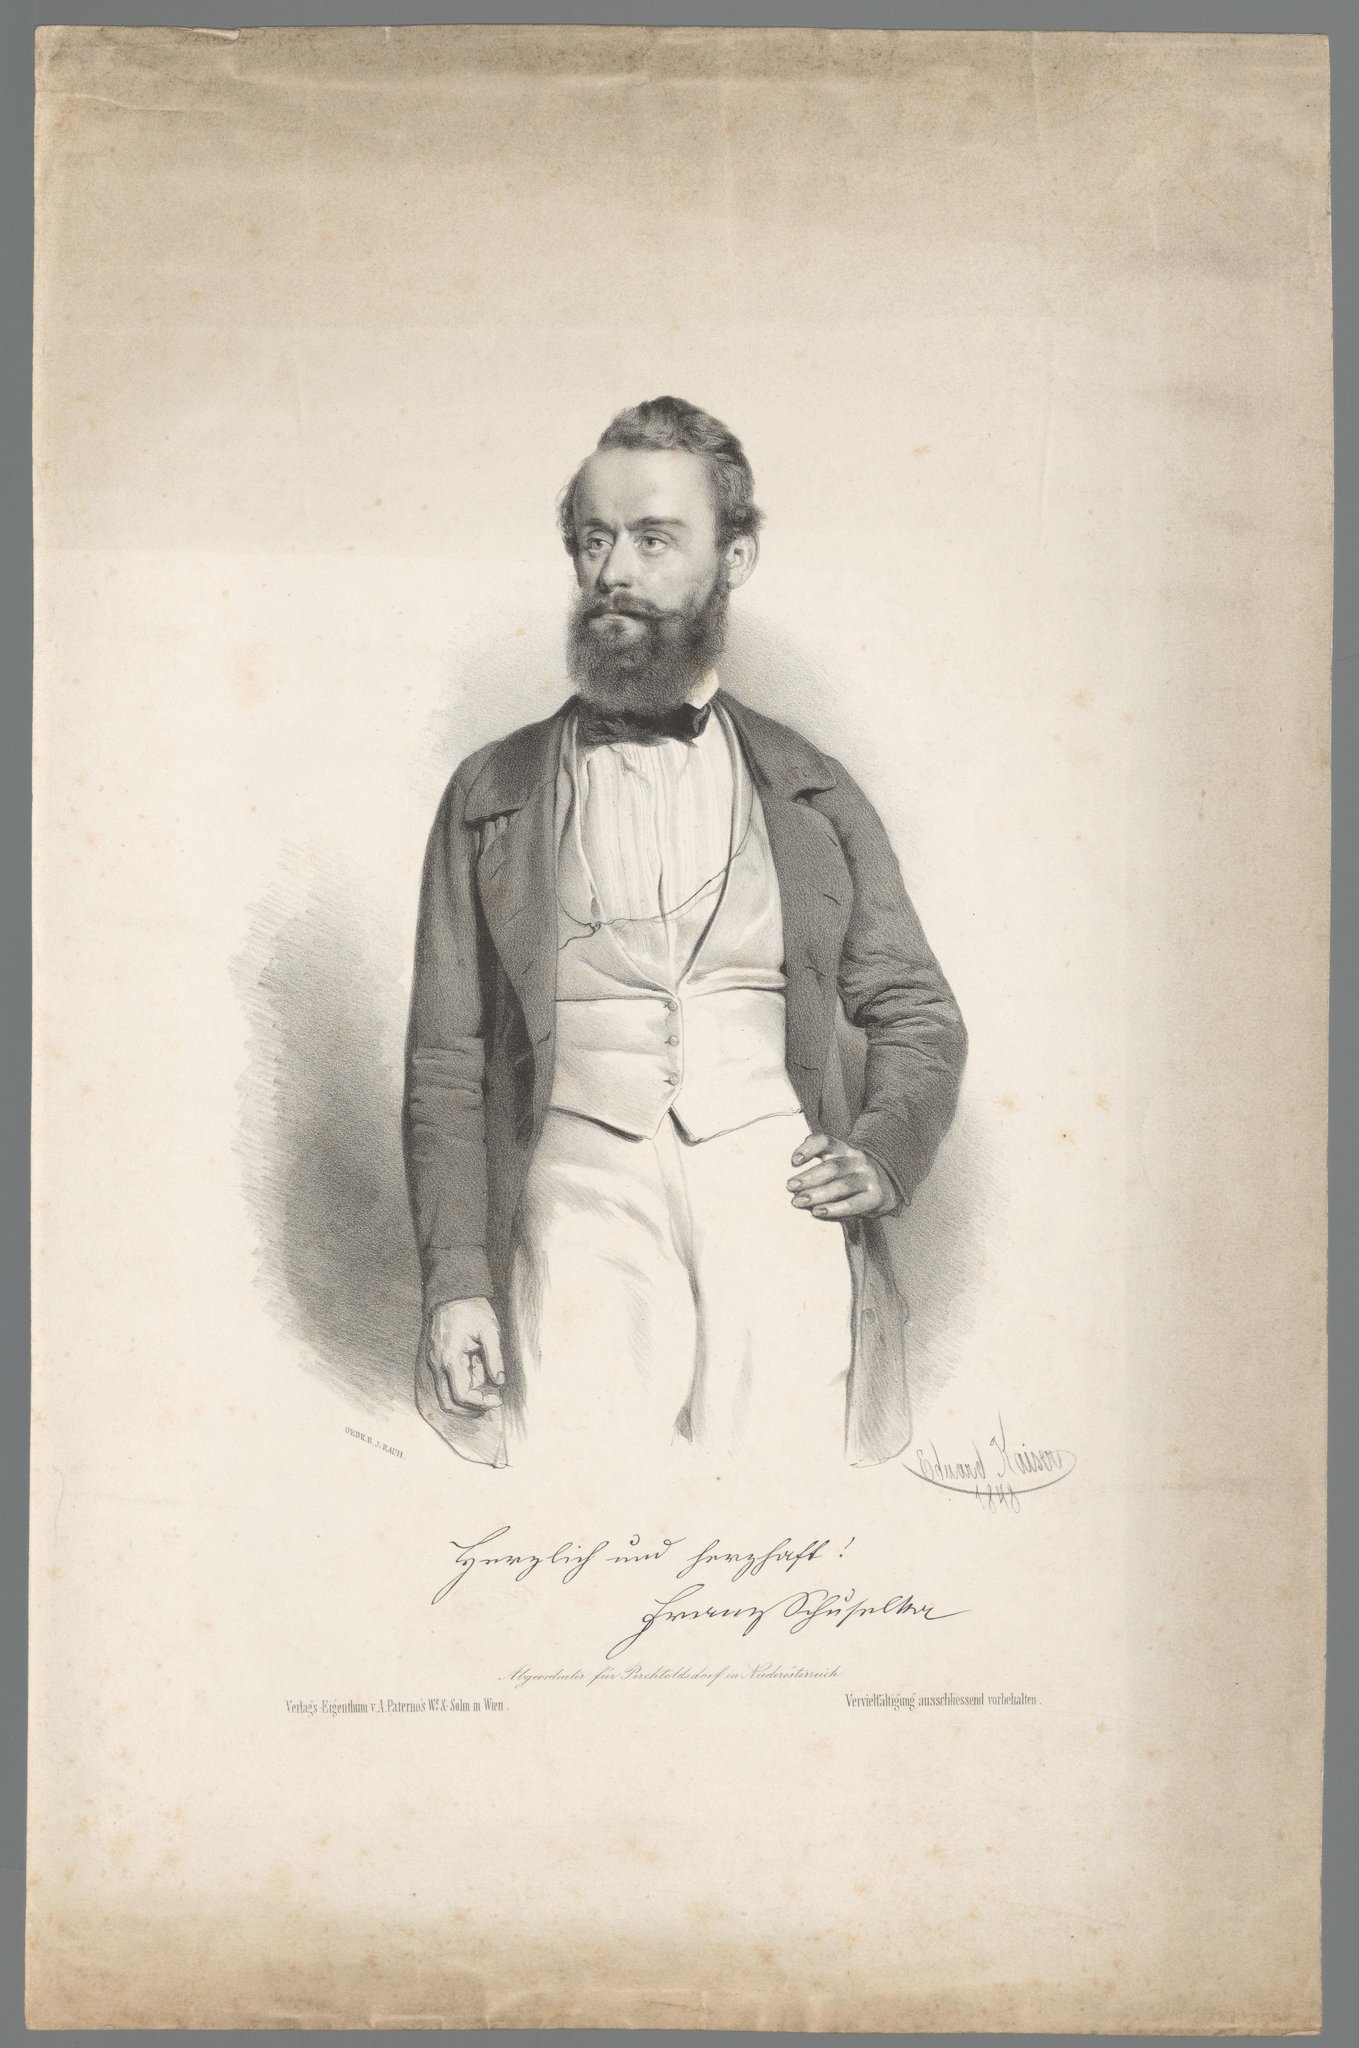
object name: print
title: Portret van een onbekende man, mogelijk Henry Schuselster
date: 1848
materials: paper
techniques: lithograph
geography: vienna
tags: adult man, historical persons, beard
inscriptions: check stamp: ‘A. Paterno s Wtwe. & Sohn Kunsthandlung in Wien’, collector's mark: Lugt 2228